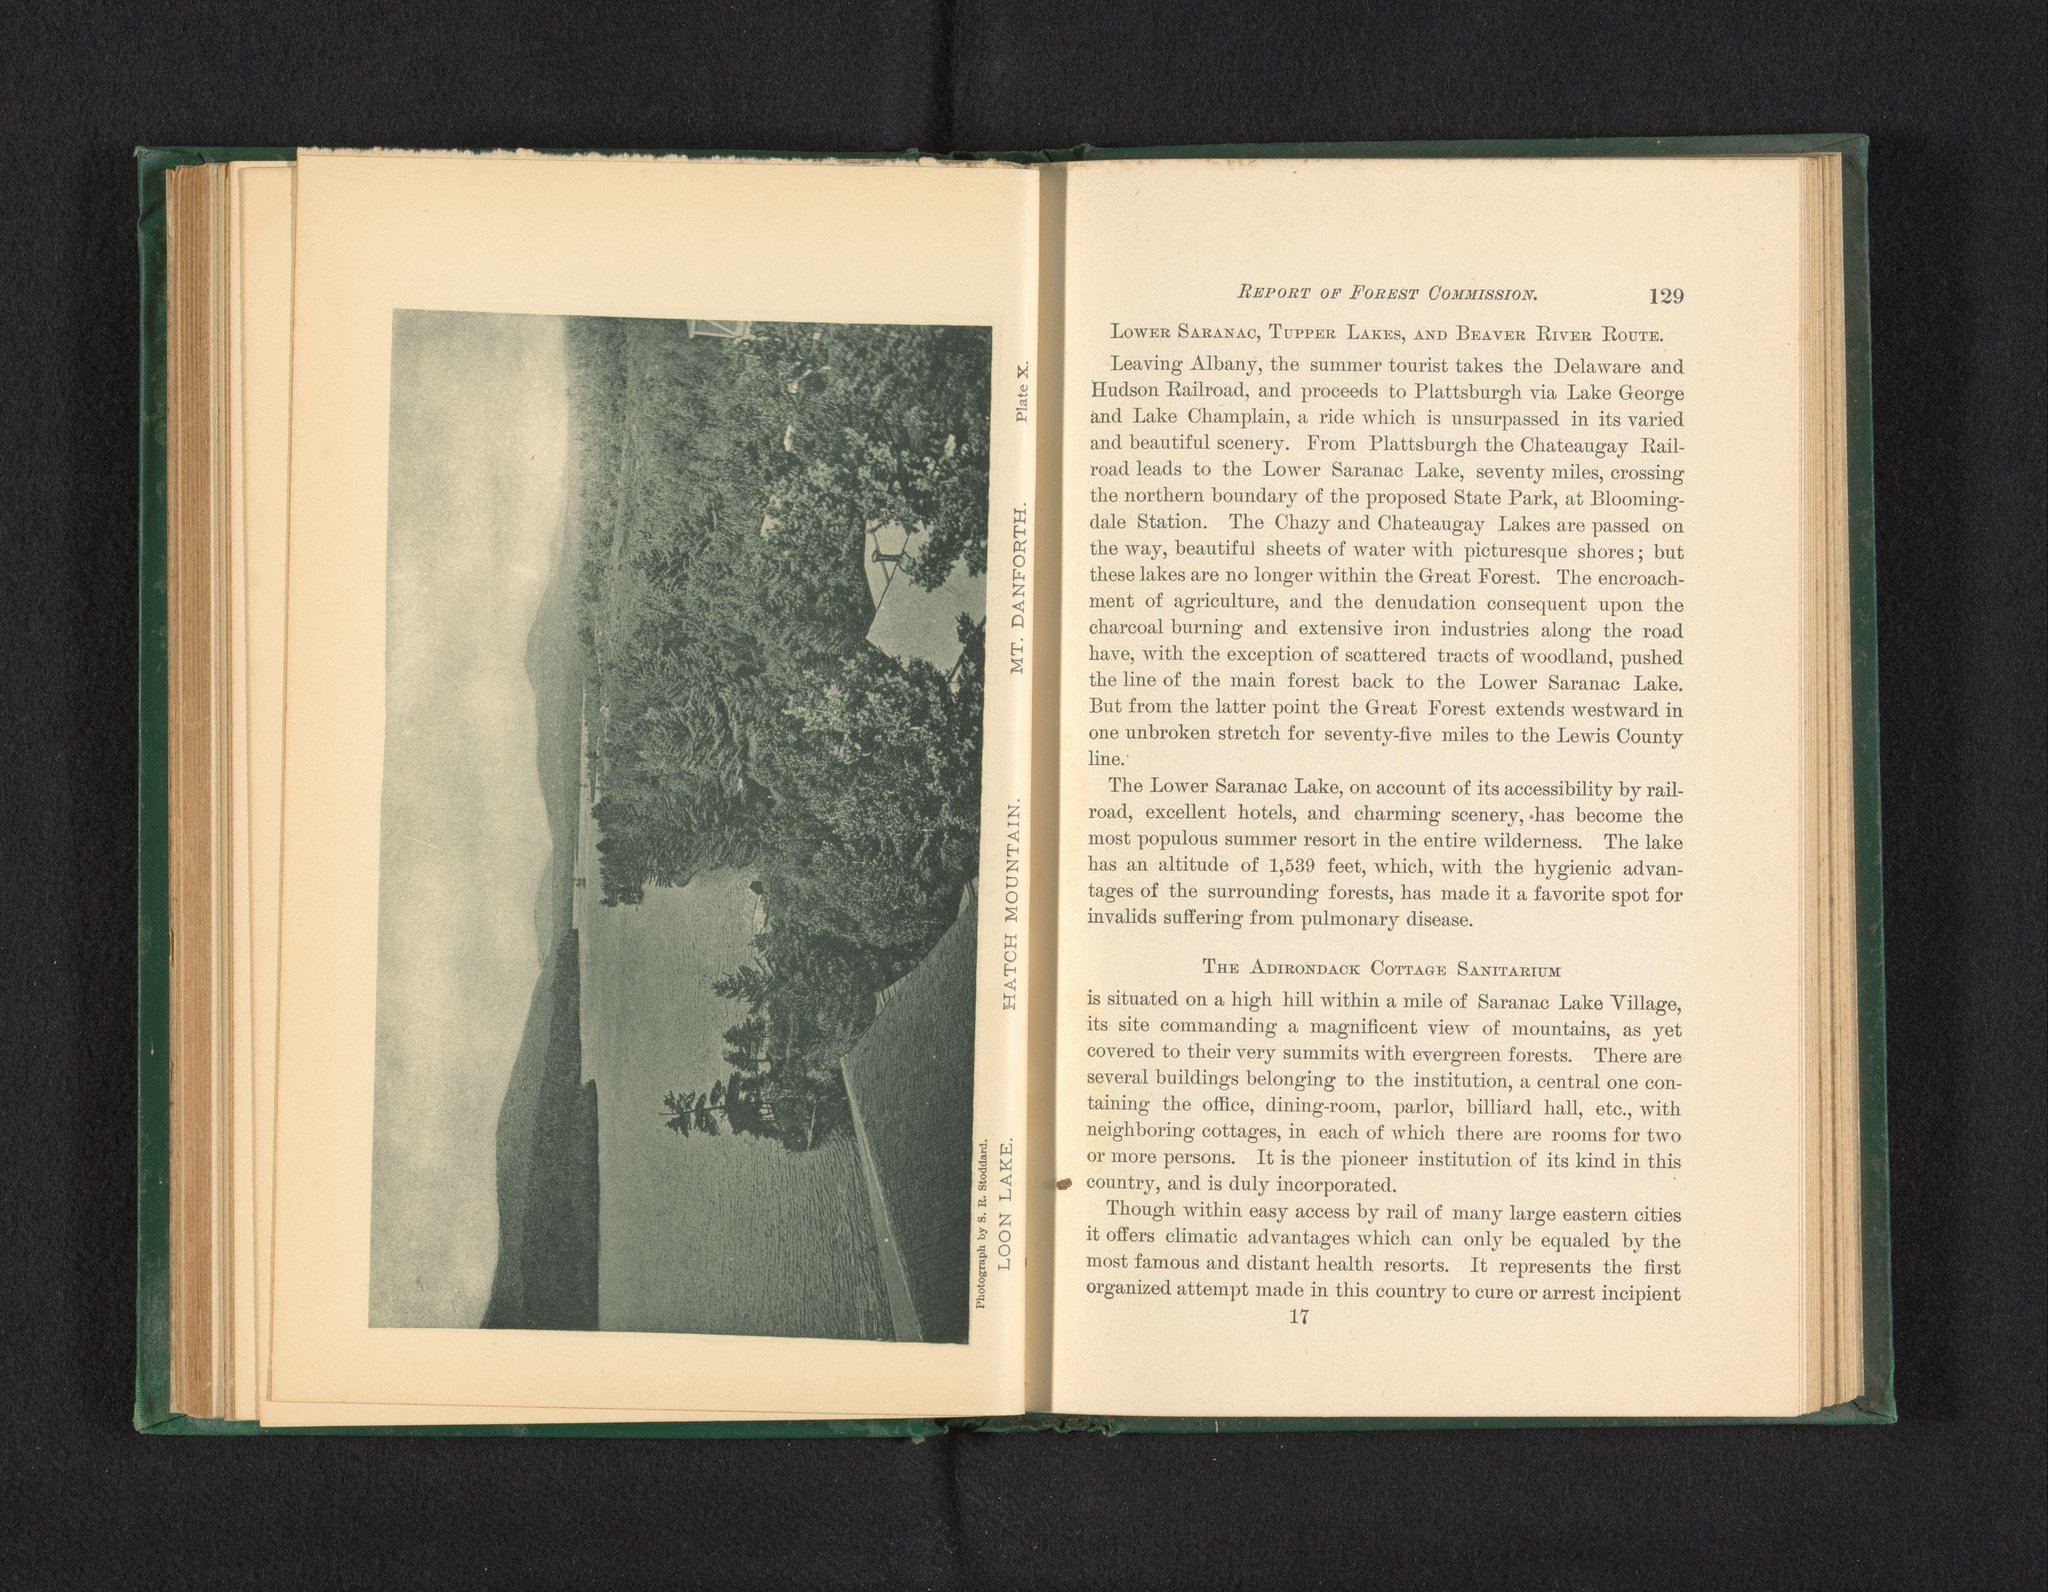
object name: page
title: Loon Lake. Hatch Mountain. Mt. Danforth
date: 1891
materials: paper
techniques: photograph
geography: new york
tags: landscapes with waters, waterscapes, seascapes (in the temperate zone), lake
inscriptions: number: ‘Plate X.’